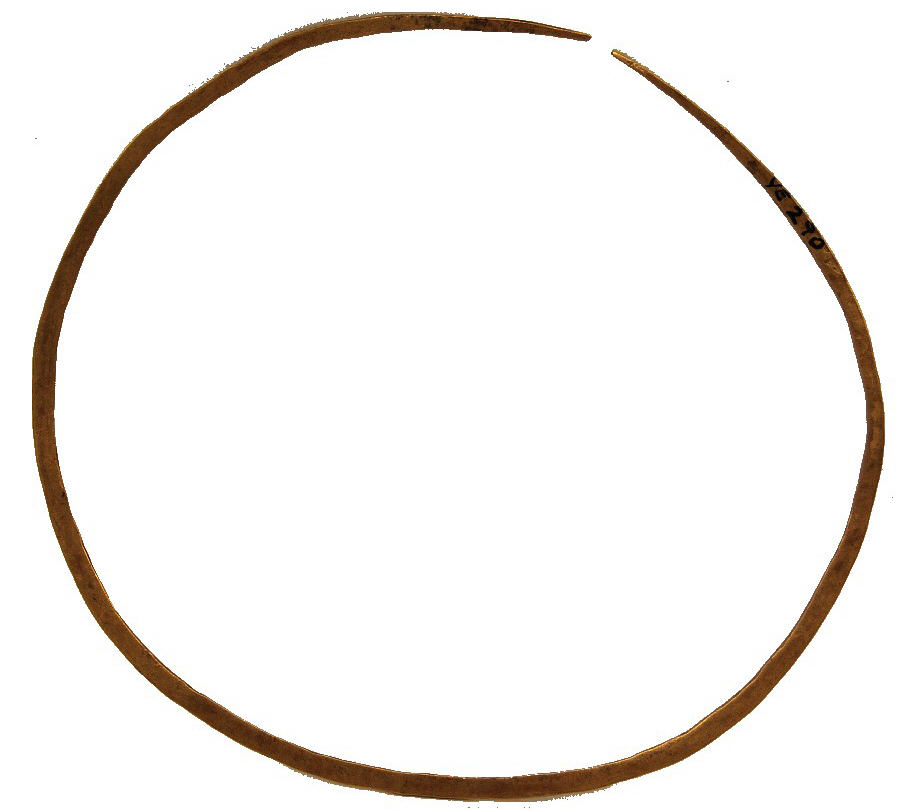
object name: nose ornament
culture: sonso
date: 1101-1500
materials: gold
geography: colombia